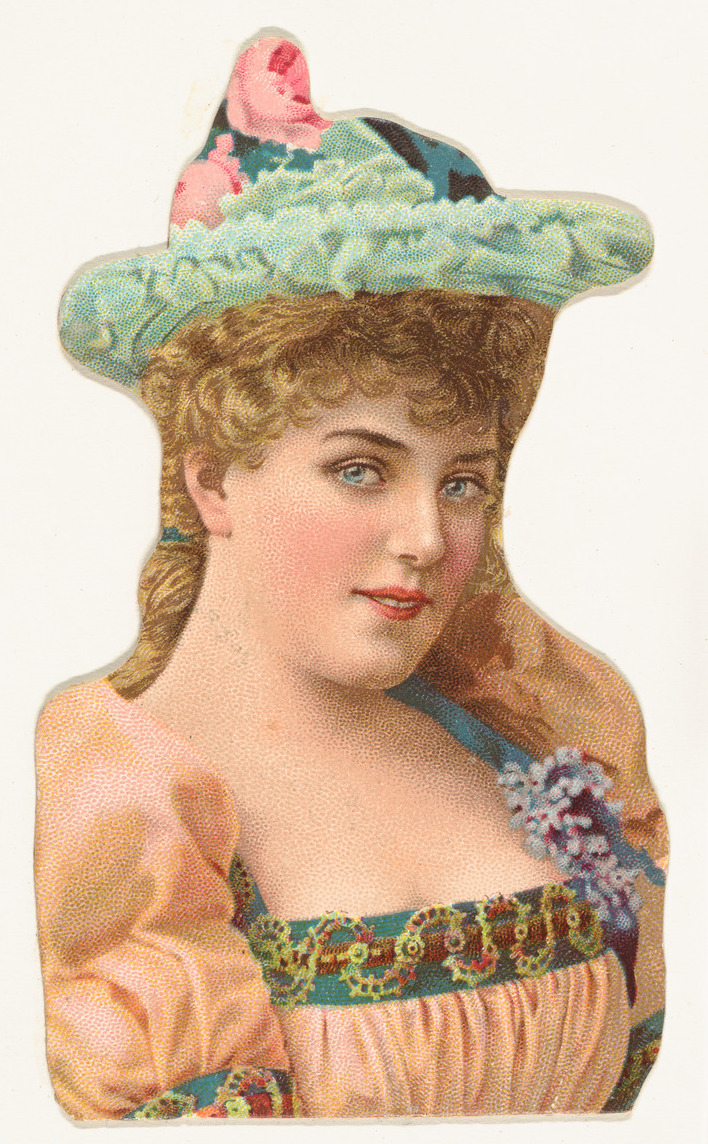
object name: print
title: Actress wearing blue hat with pink roses, from Stars of the Stage, Fourth Series (N132) issued by Duke Sons & Co. to promote Honest Long Cut Tobacco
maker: w. duke, sons & co.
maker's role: publisher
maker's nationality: american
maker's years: 1870-1920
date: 1892-1893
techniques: color lithograph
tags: portraits,women,actresses